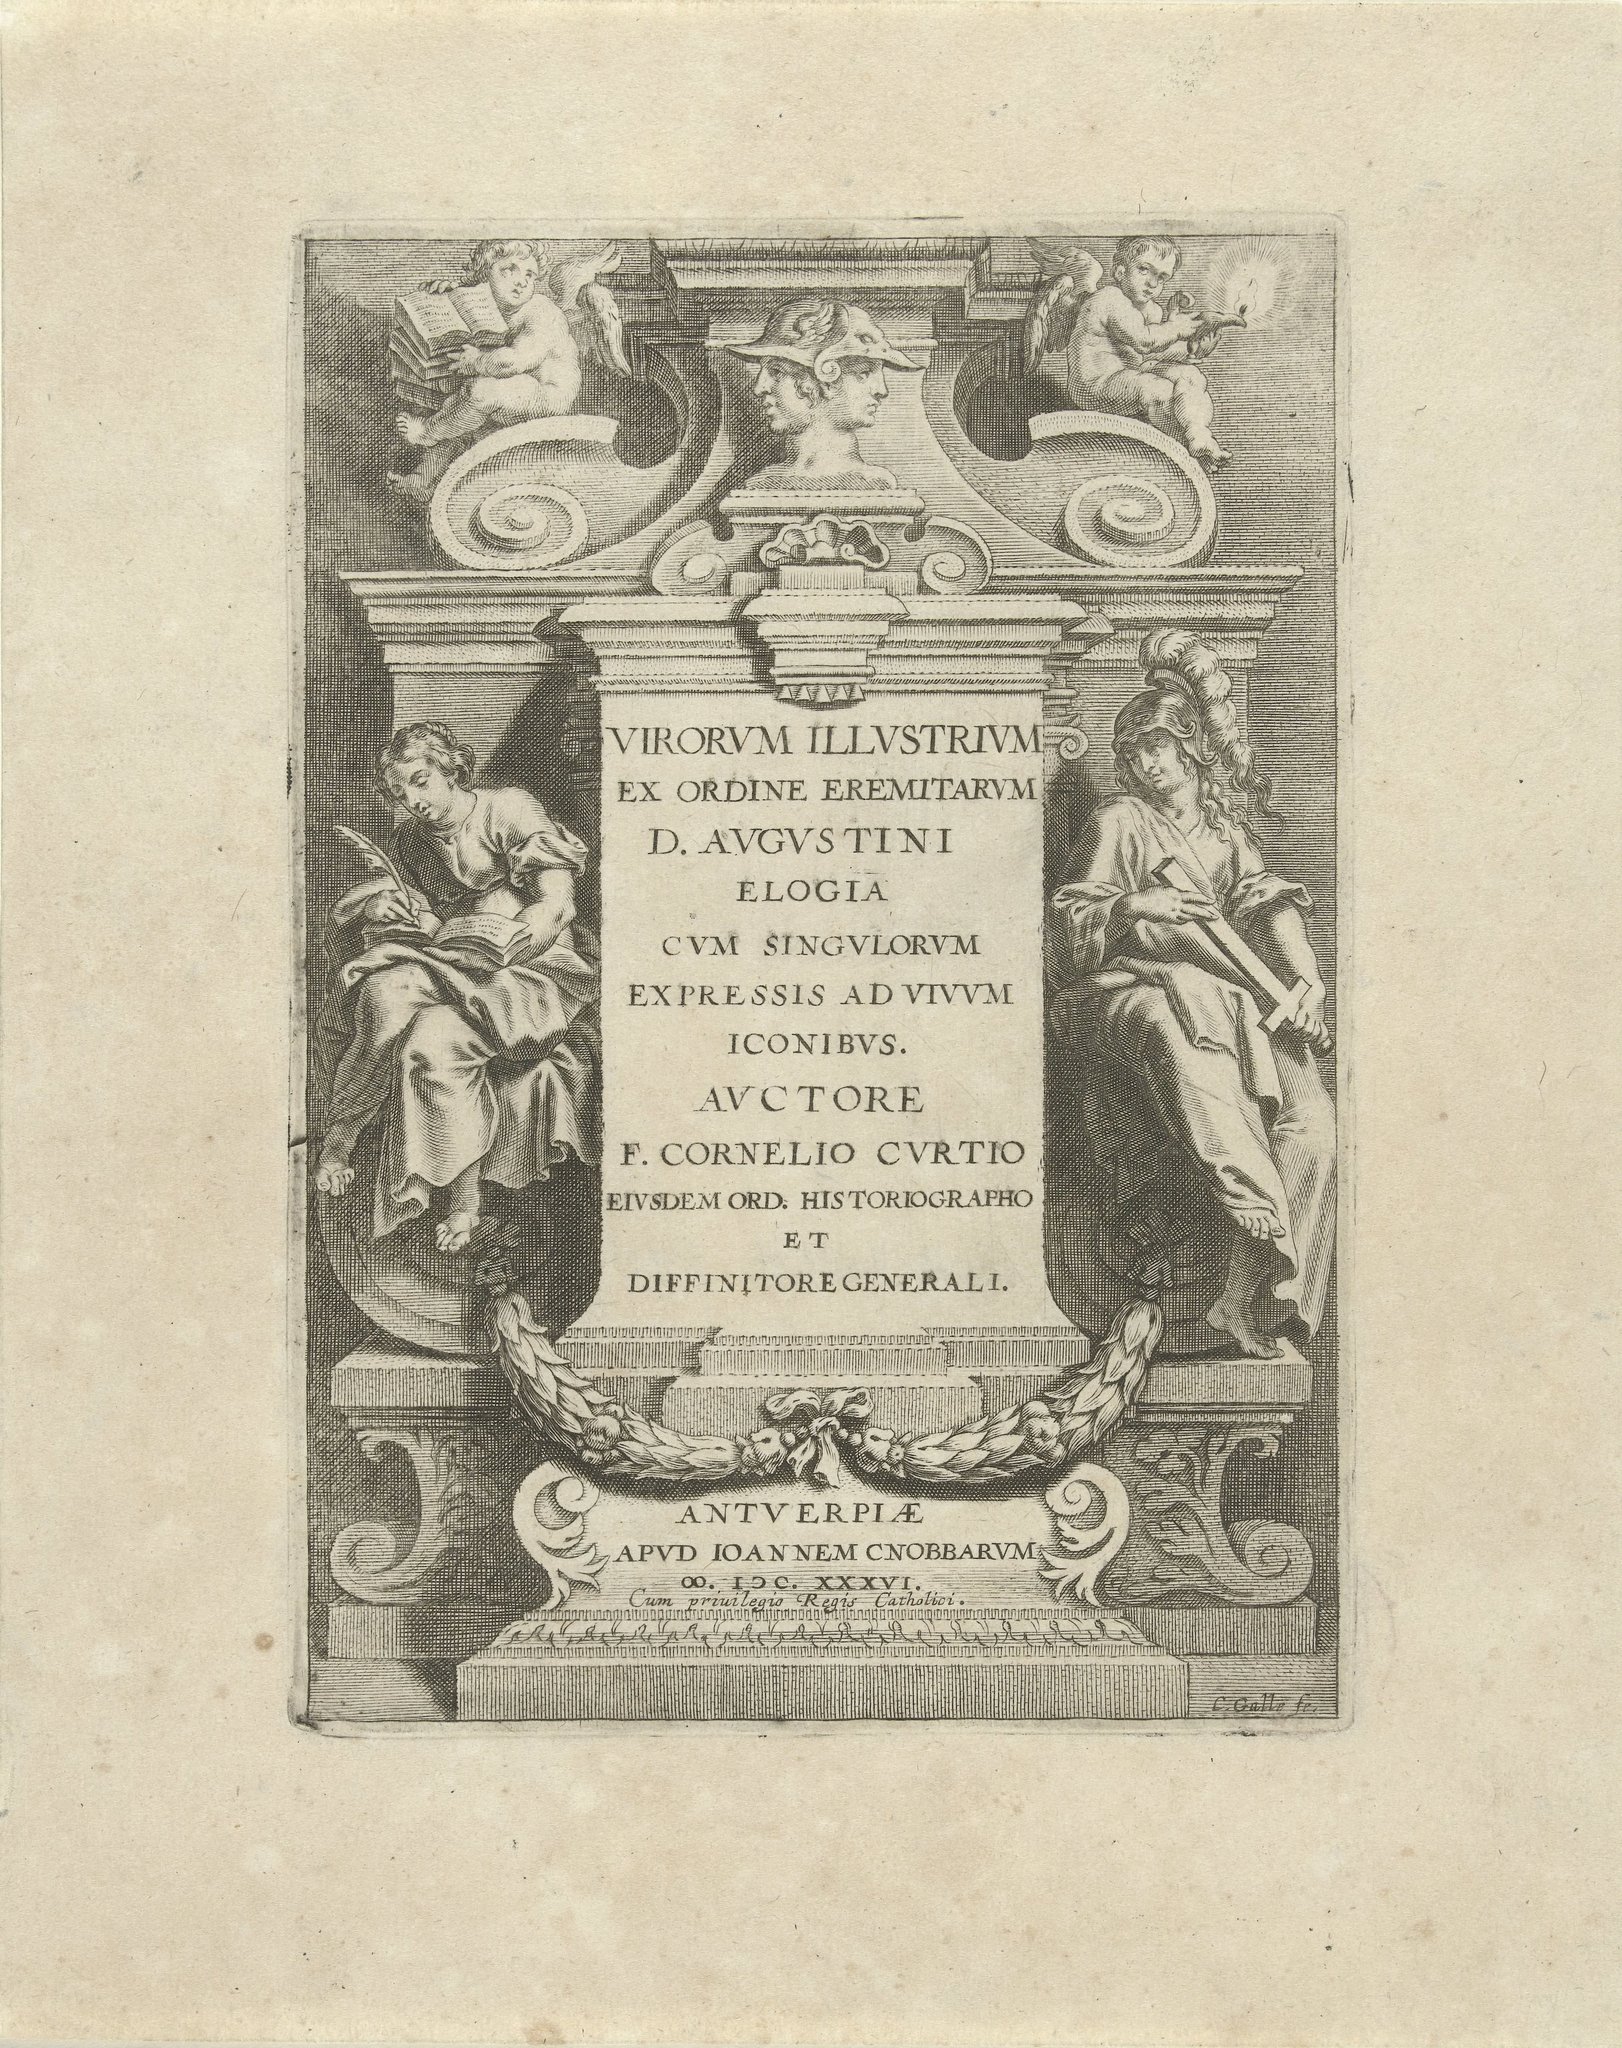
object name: print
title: Titelpagina voor: Cornelius Curtius, Virorum illustrium ex ordine Eremitarum D. Augustini elogia , Antwerpen: 1636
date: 1636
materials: paper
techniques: engraving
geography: antwerp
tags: title-page, 'historia'; 'historia' (ripa)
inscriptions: collector's mark: Lugt 240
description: Stenen tafel met de titel van het boek. Aan weerszijden twee vrouwelijke beelden. Links een vrouw die met een veer in een boek schrijft. Wellicht een personificatie van de geschiedschrijving. Rechts een vrouw met helm en houten zwaard. Boven de tafel een Januskop en twee putti.